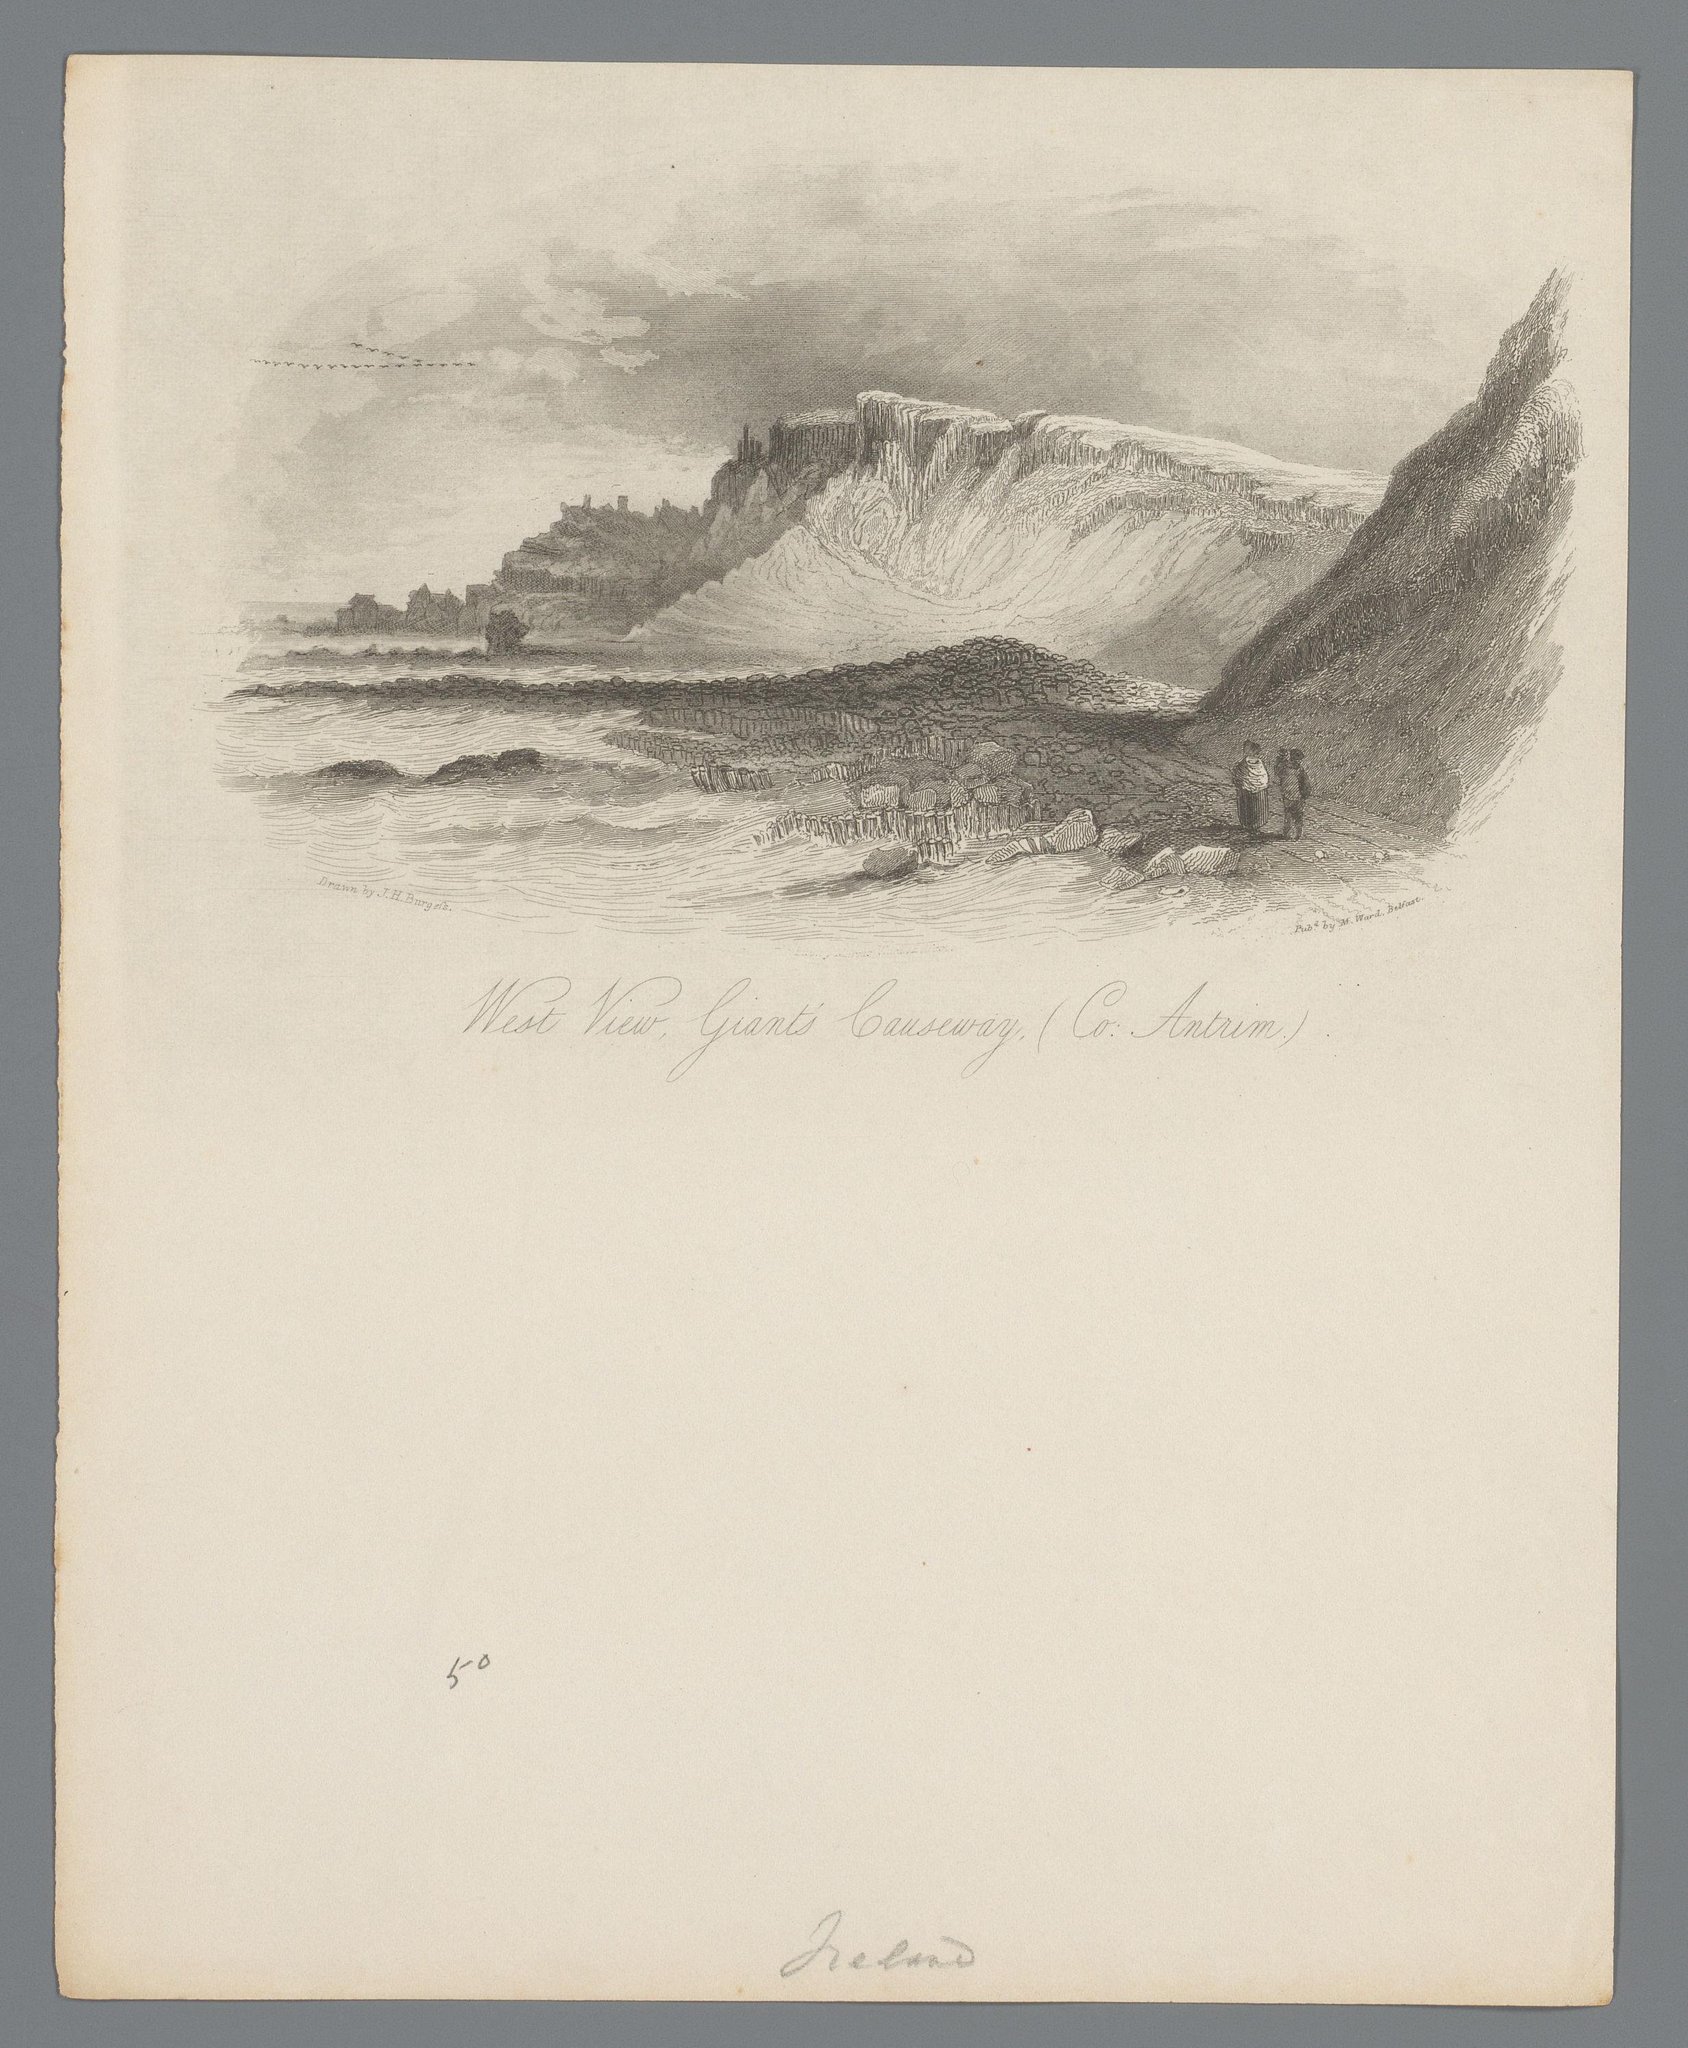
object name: print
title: Briefpapier met voorstelling van de Giant's Causeway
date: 1833-1847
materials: paper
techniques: engraving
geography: belfast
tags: rocky coast